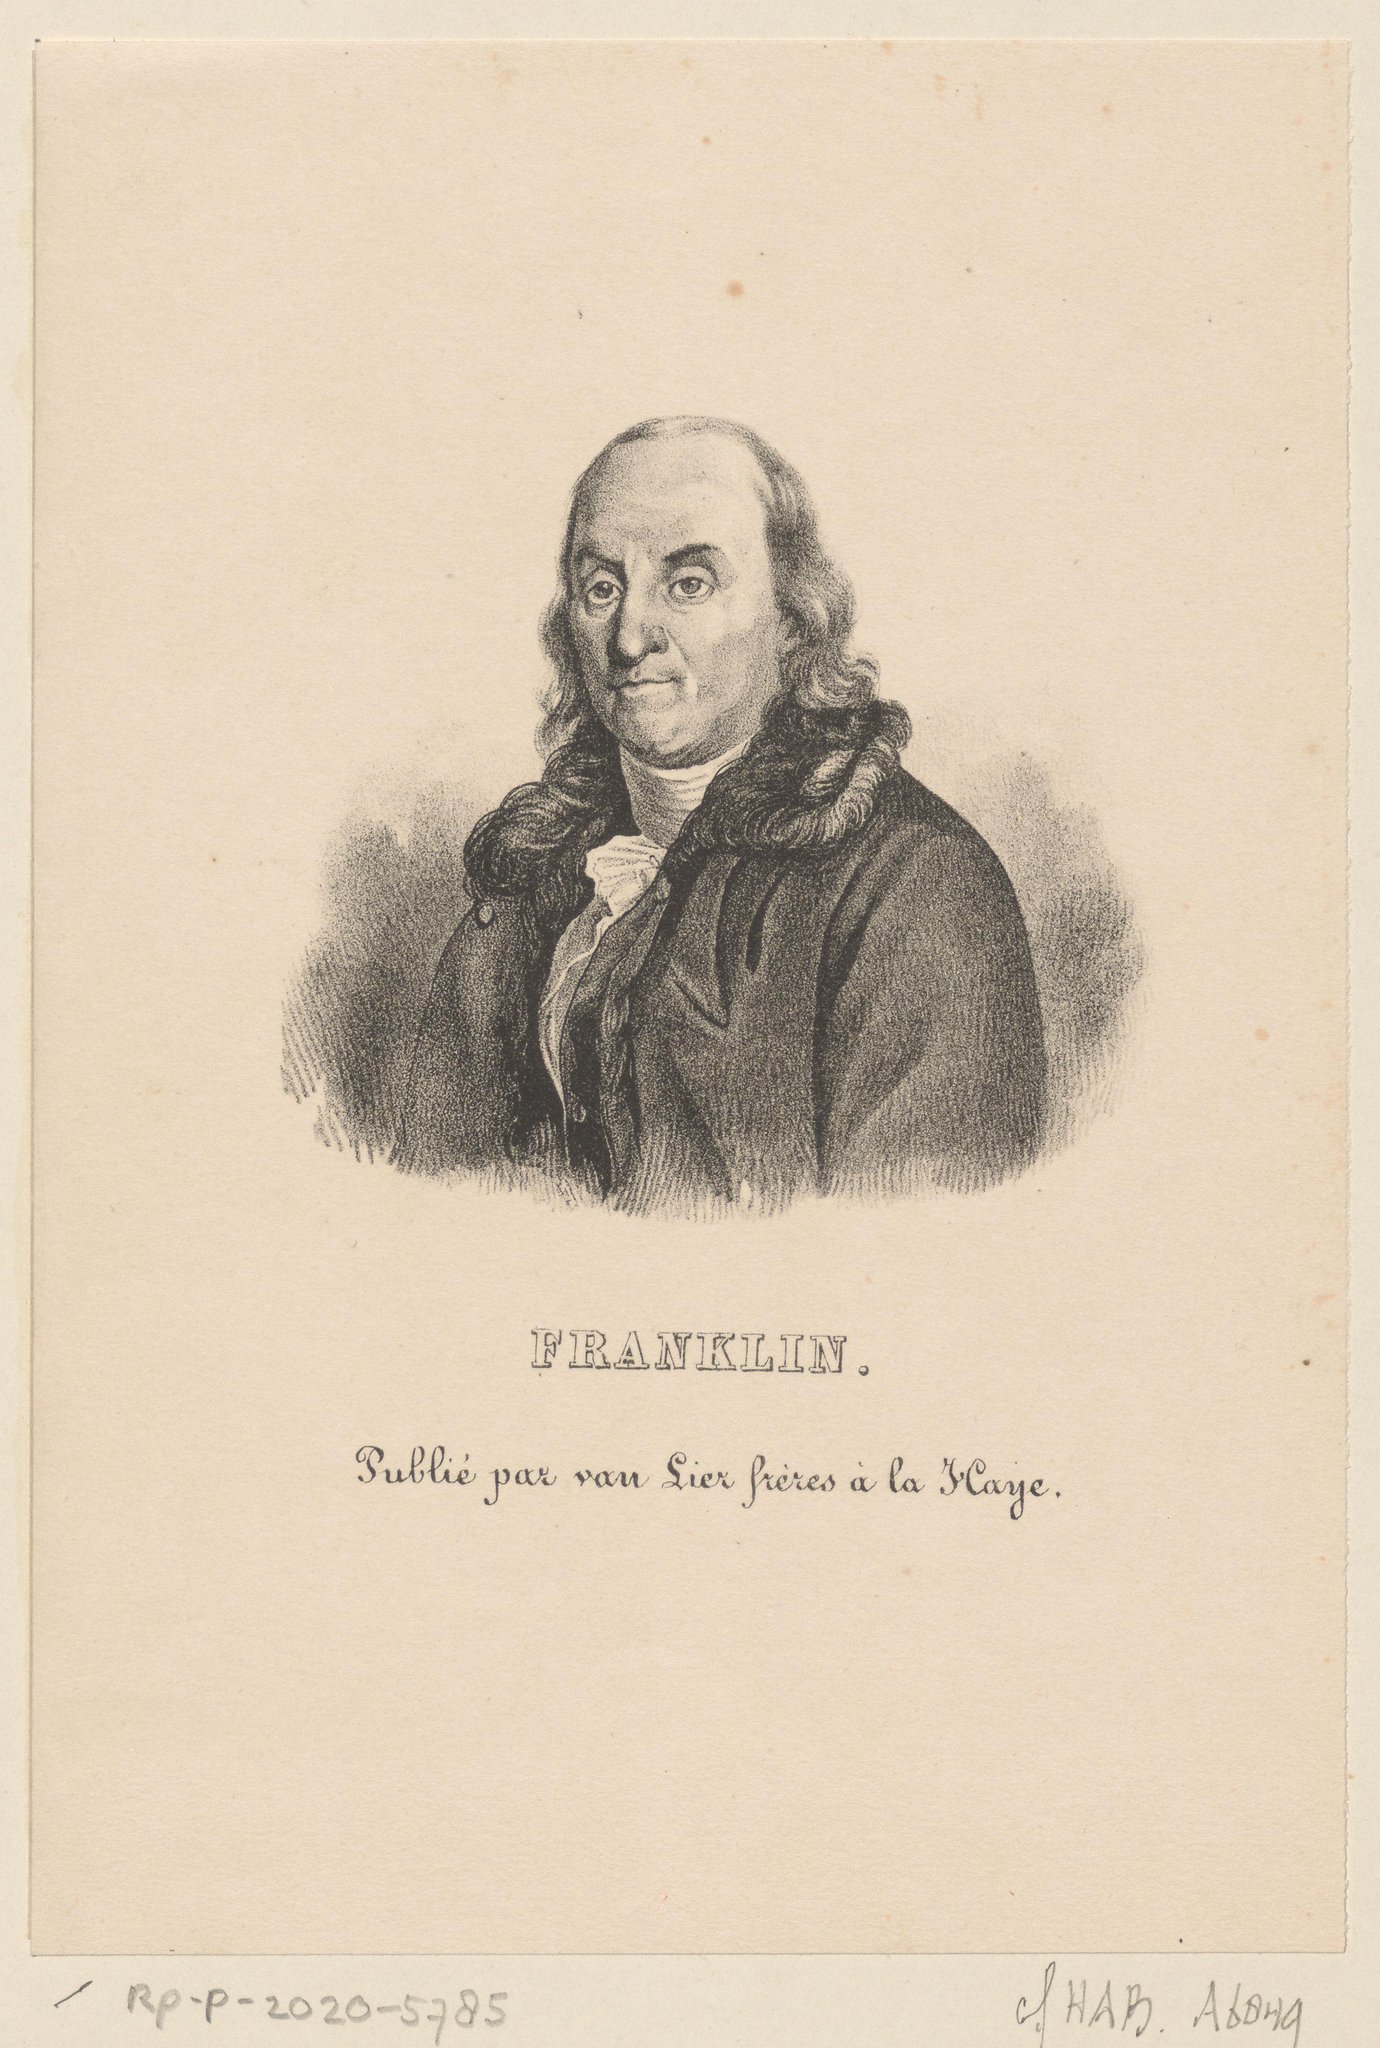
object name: print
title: Portret van Benjamin Franklin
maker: Anonymous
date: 1833-1846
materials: paper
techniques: lithograph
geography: the hague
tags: physicist, historical persons, politician, e.g. party leader